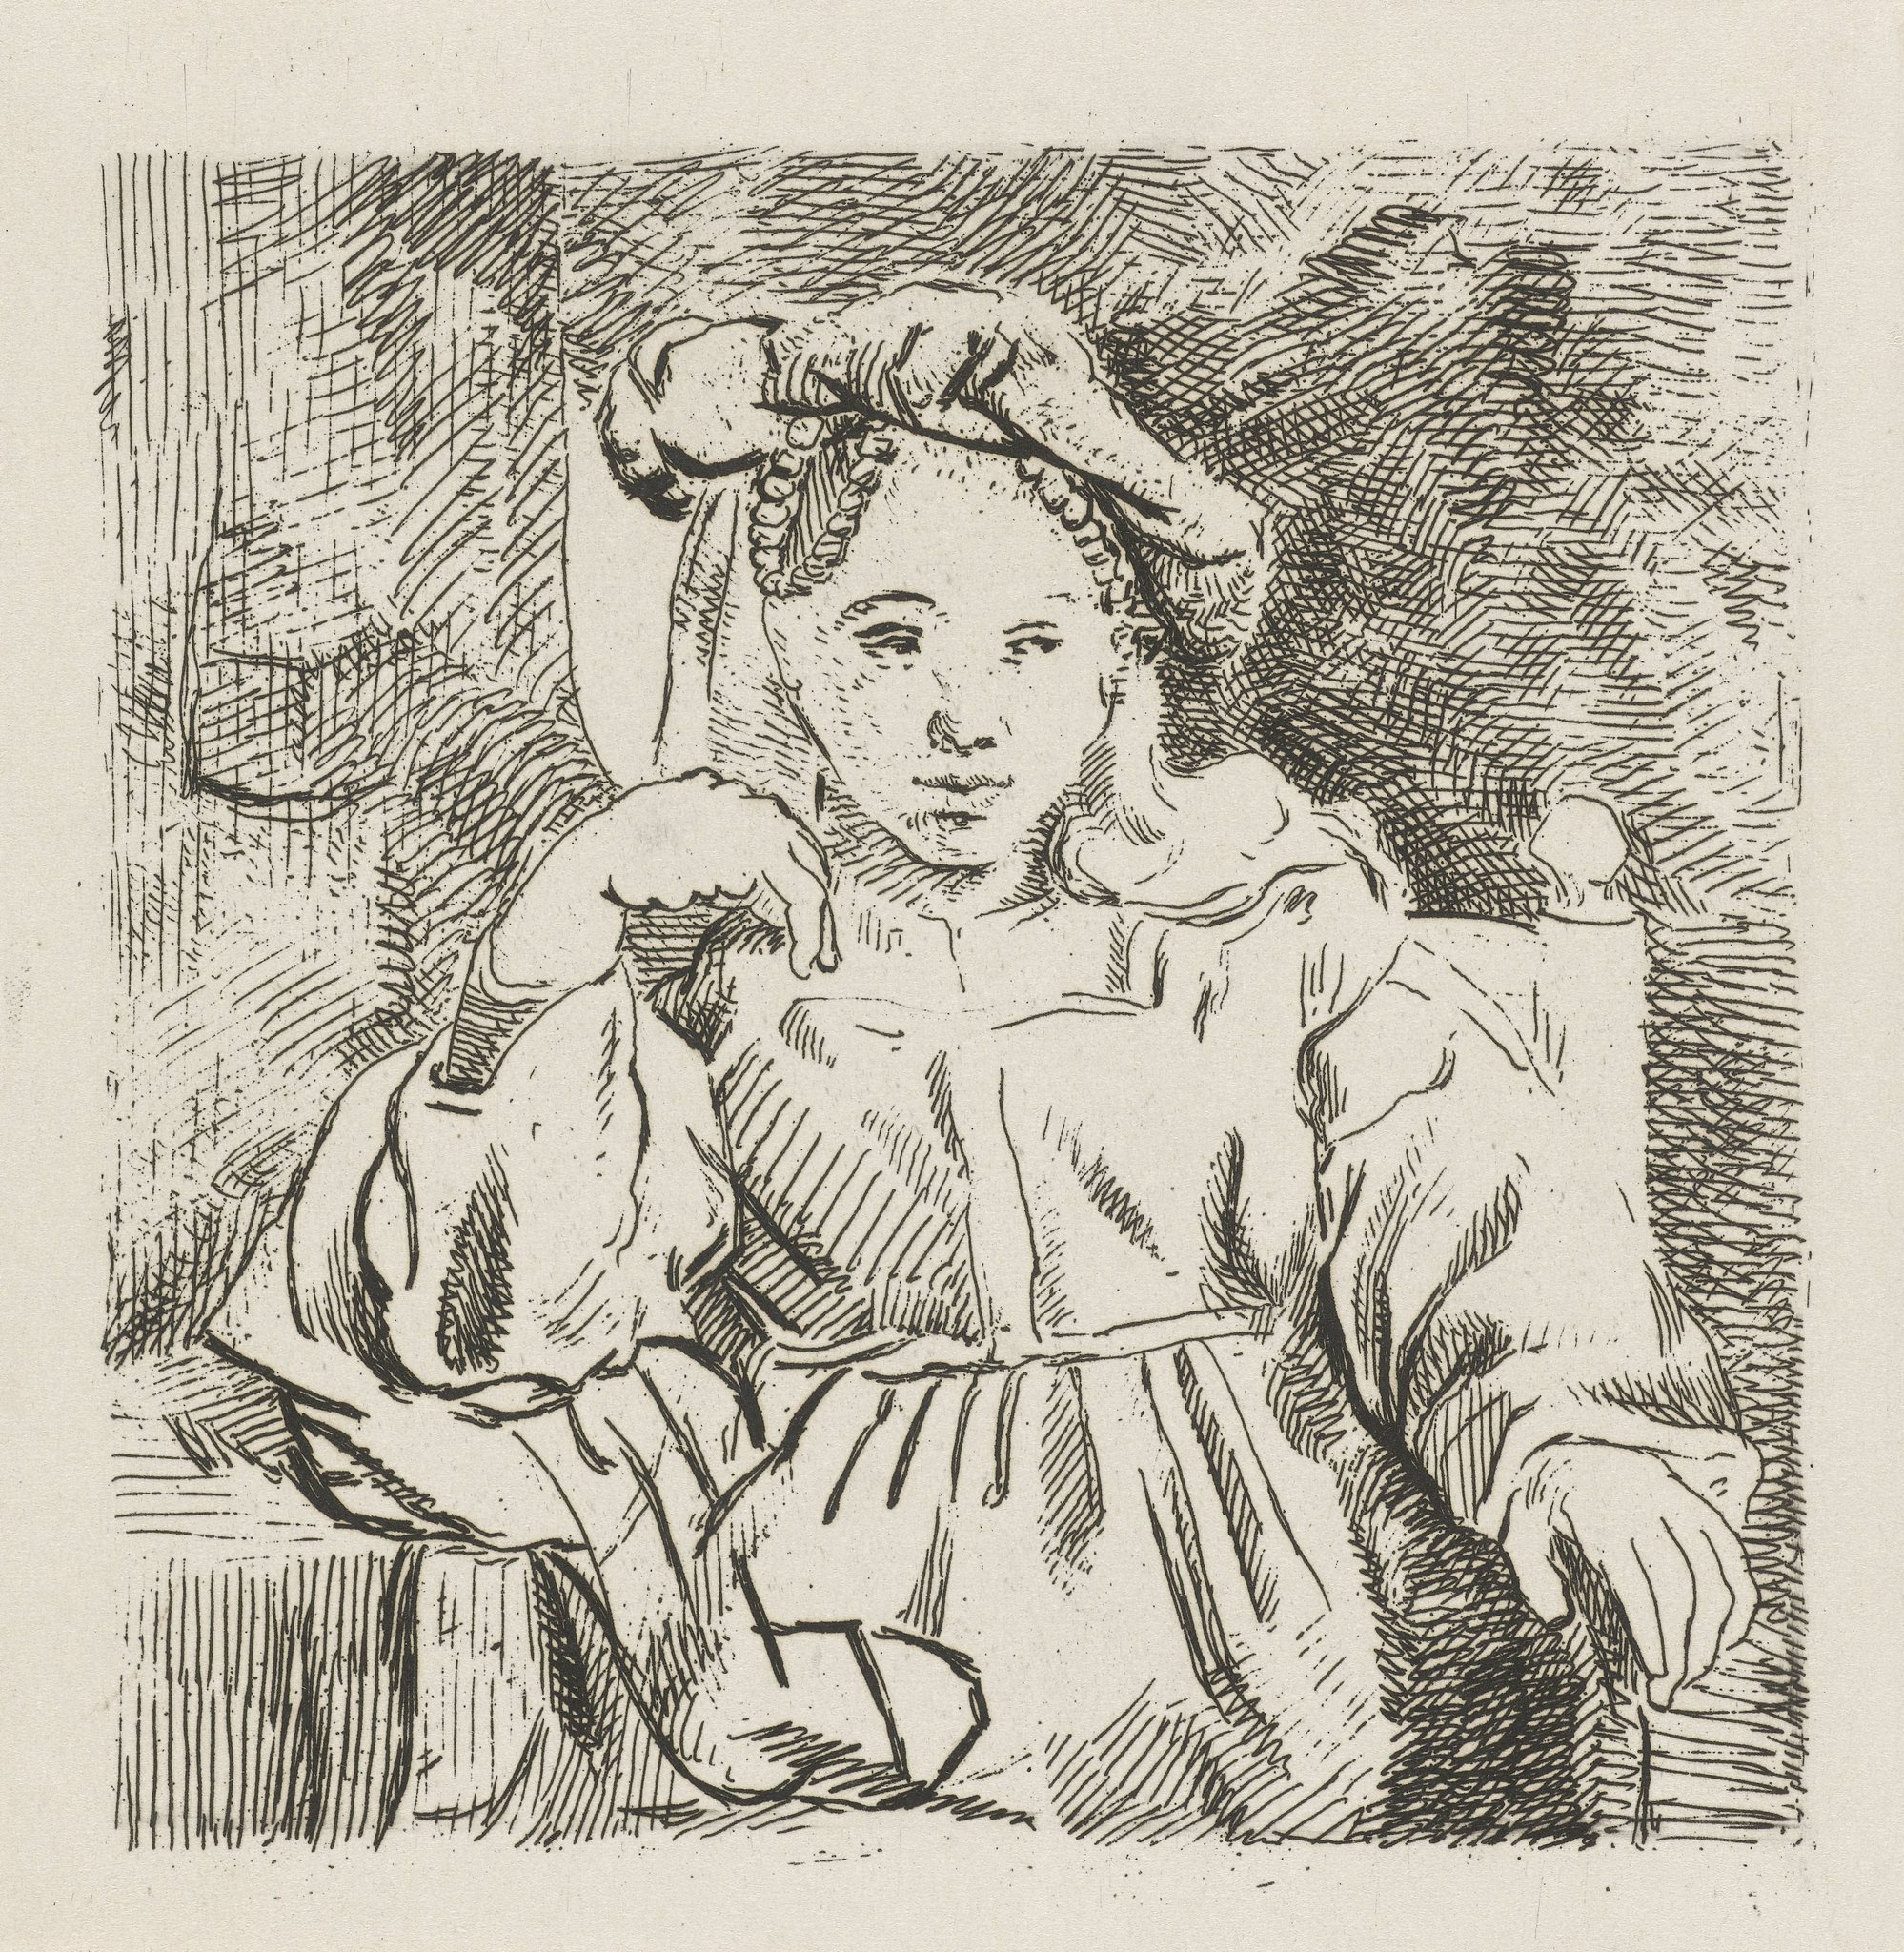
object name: print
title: Zittend meisje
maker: david van der kellen (1804-1879)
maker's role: die cutter, draughtsman, print maker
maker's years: 1804-1879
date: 1814-1859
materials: paper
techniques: etching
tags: adolescent, young woman, maiden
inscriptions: collector's mark: Lugt 2228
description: Een meisje, getooid met een baret, zit in een stoel, terwijl ze met haar elleboog op de tafel naast haar leunt.